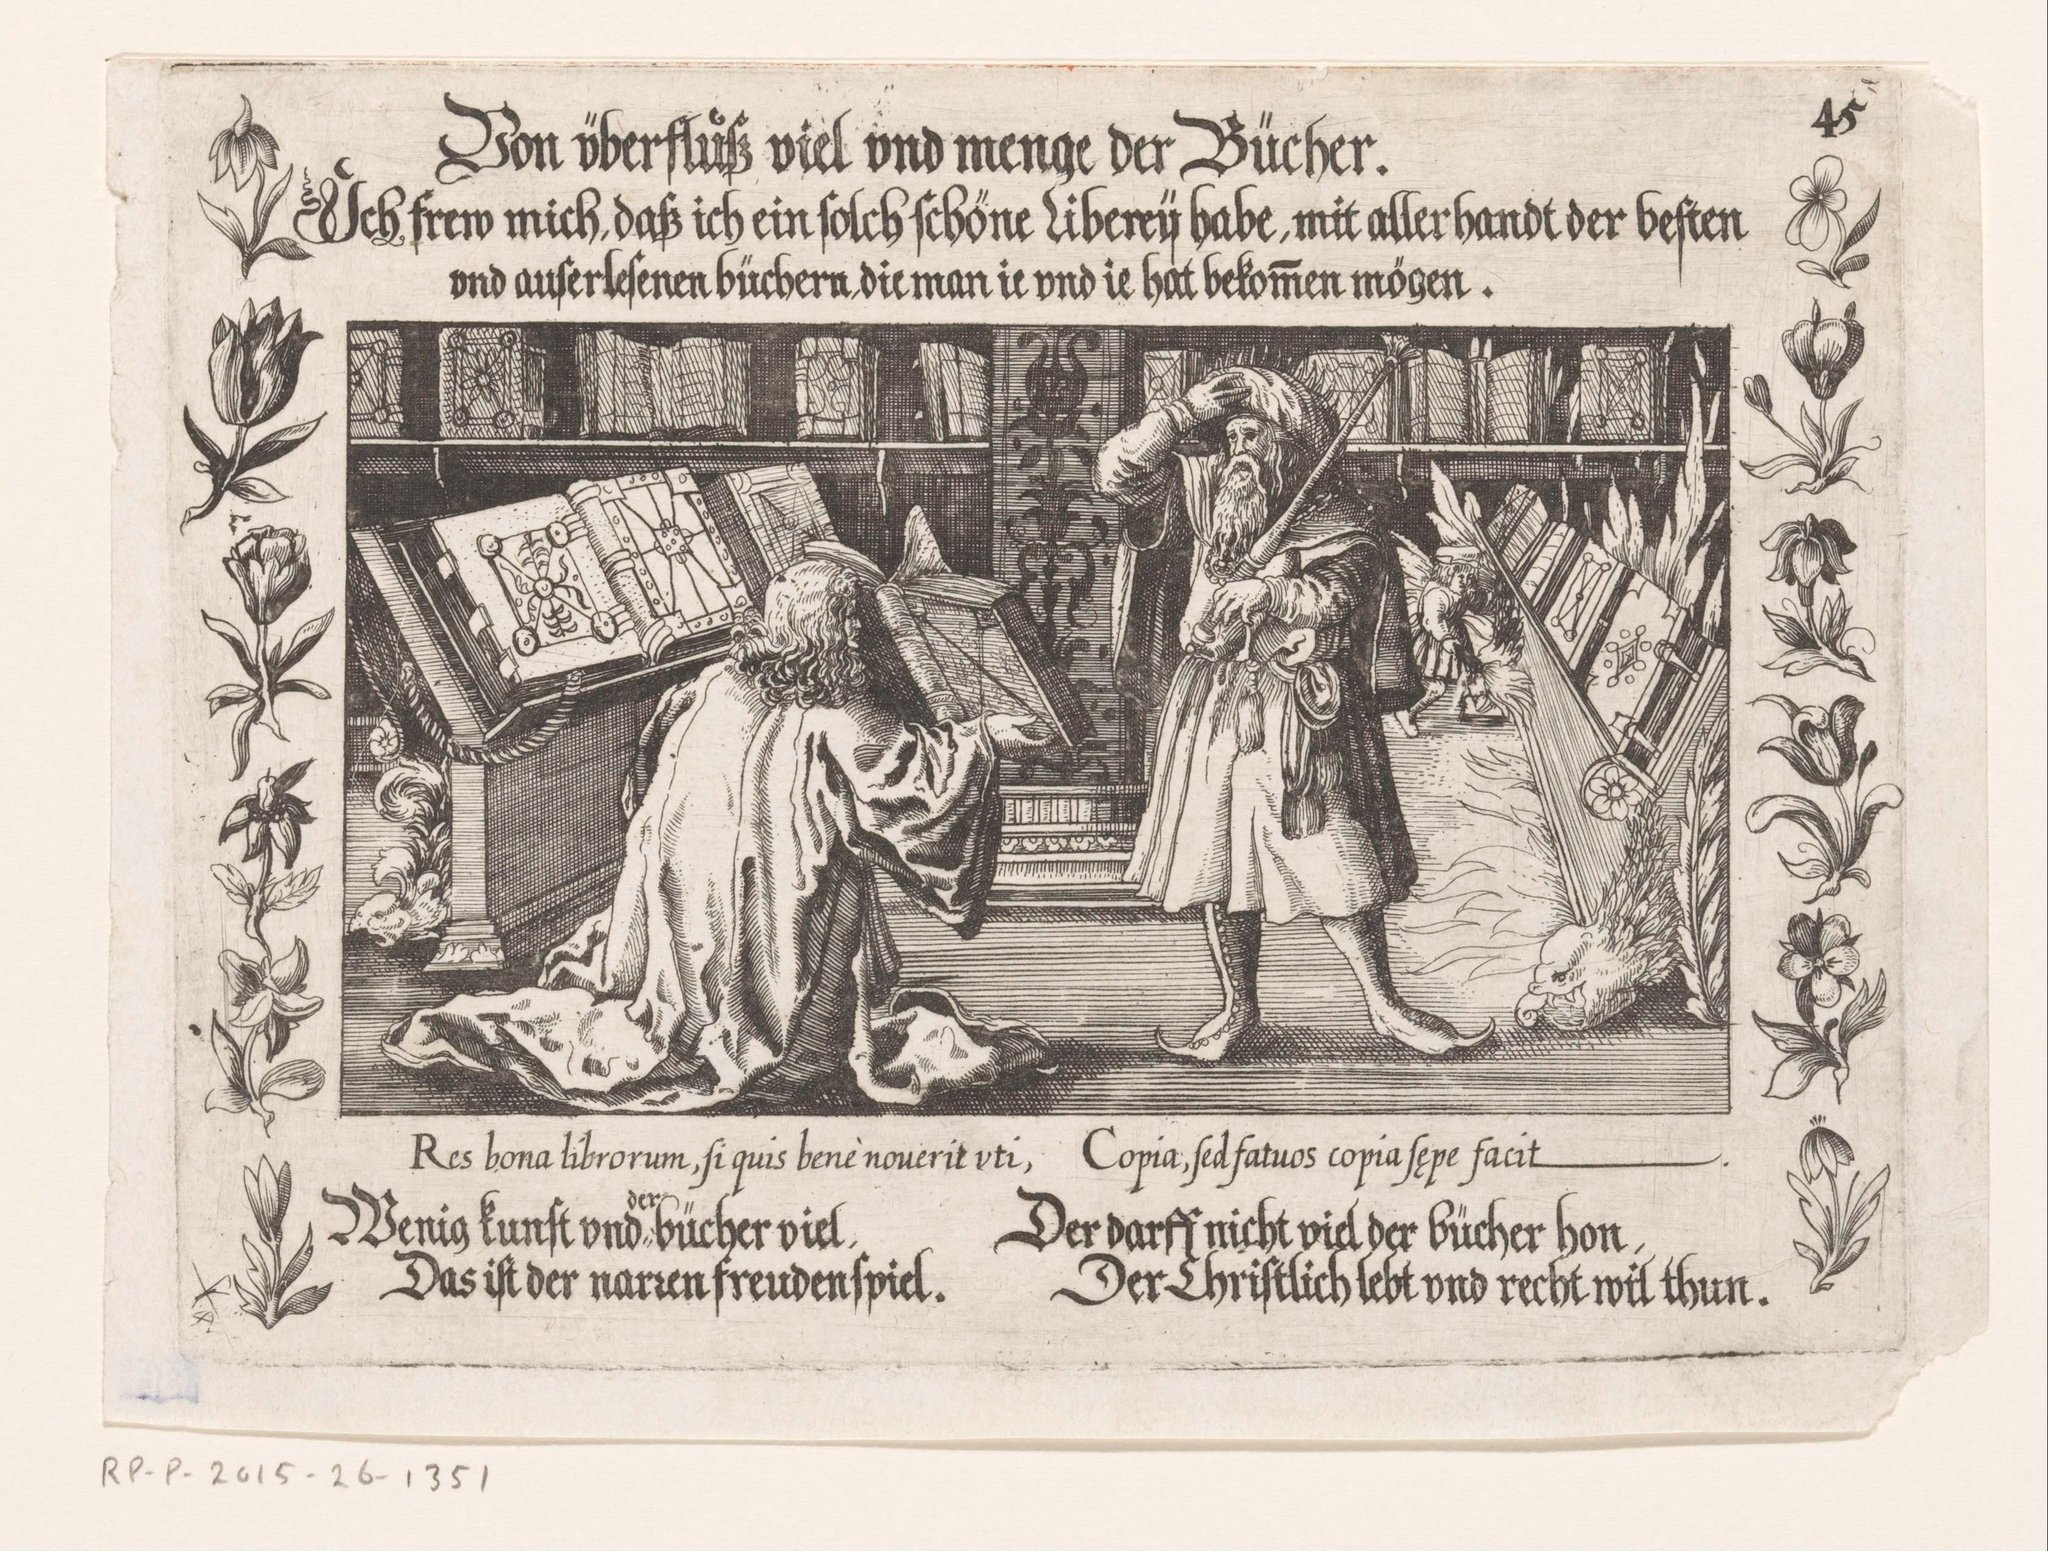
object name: print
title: Boekaanbieding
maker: Anonymous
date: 1532-1650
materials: paper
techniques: etching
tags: bookshelves, ruler, sovereign, lectern ~ reading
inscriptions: collector's mark: Lugt 4779, collector's mark: Lugt 2228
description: In een interieur vol boeken biedt een geknielde man een vorst een boek aan. Rechts achter de vorst steekt een jongen of putto boeken in brand. Links achter de knielende man staat een lessenaar met boeken. Met tekst in het Duits en Latijn onder en boven de afbeelding en links en rechts decoratie van bloemen.